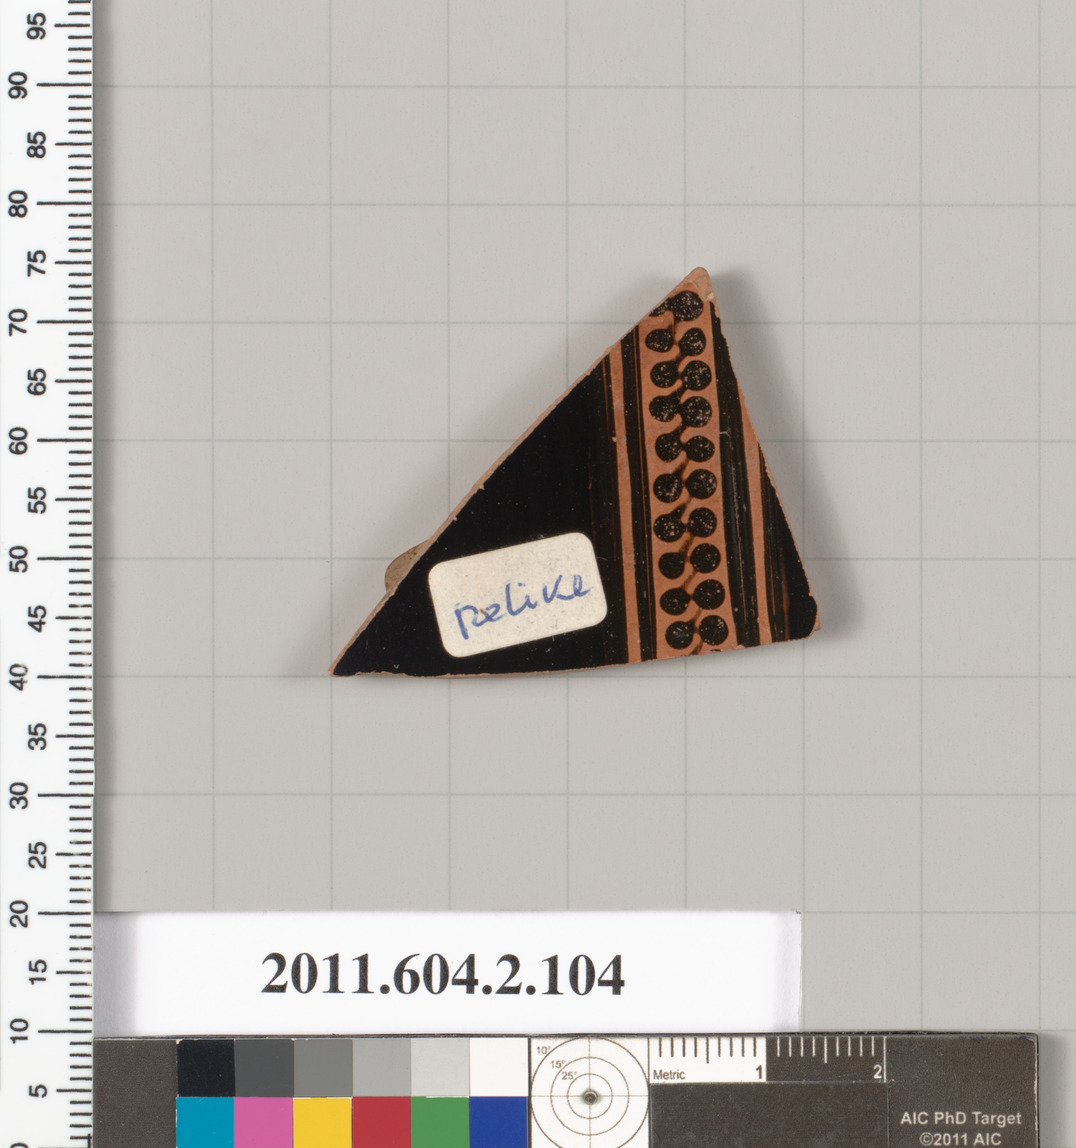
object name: pelike fragment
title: Terracotta fragment of a pelike (jar)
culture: greek, attic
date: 520-510 BCE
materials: terracotta